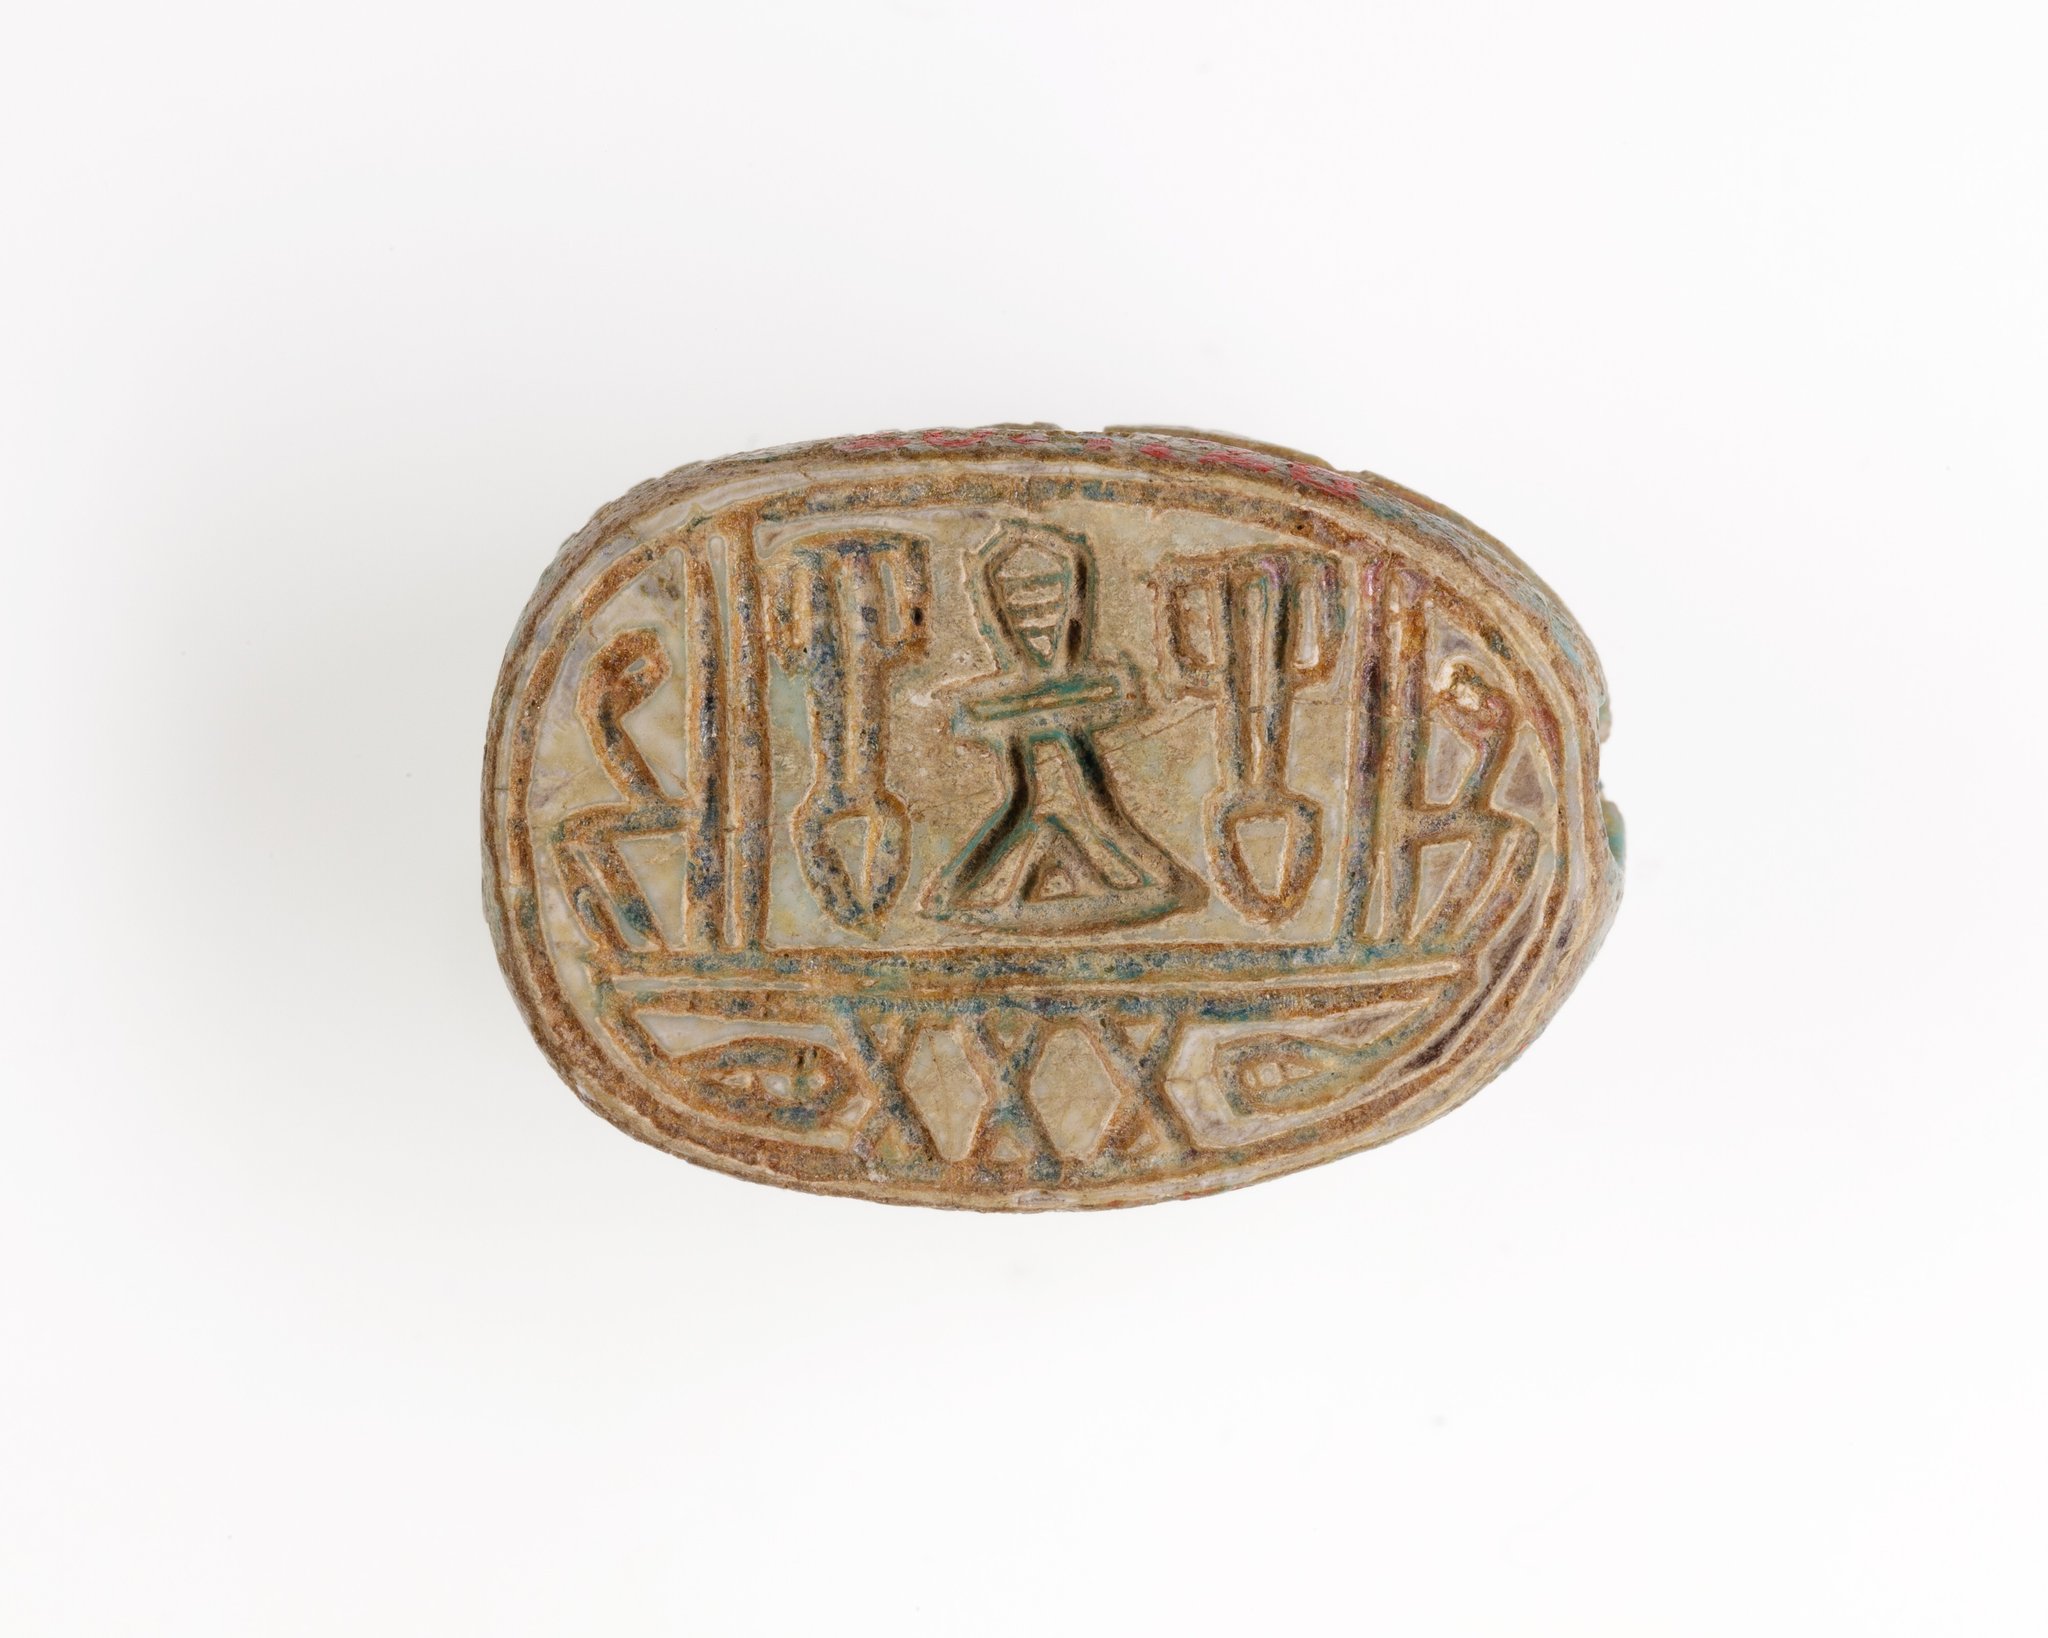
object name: scarab, papyrus, sa hieroglyph, nb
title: Scarab Inscribed with Hieroglyphs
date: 1850-1640 BCE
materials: stone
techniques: glazing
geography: egypt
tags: hieroglyphs,scarabs